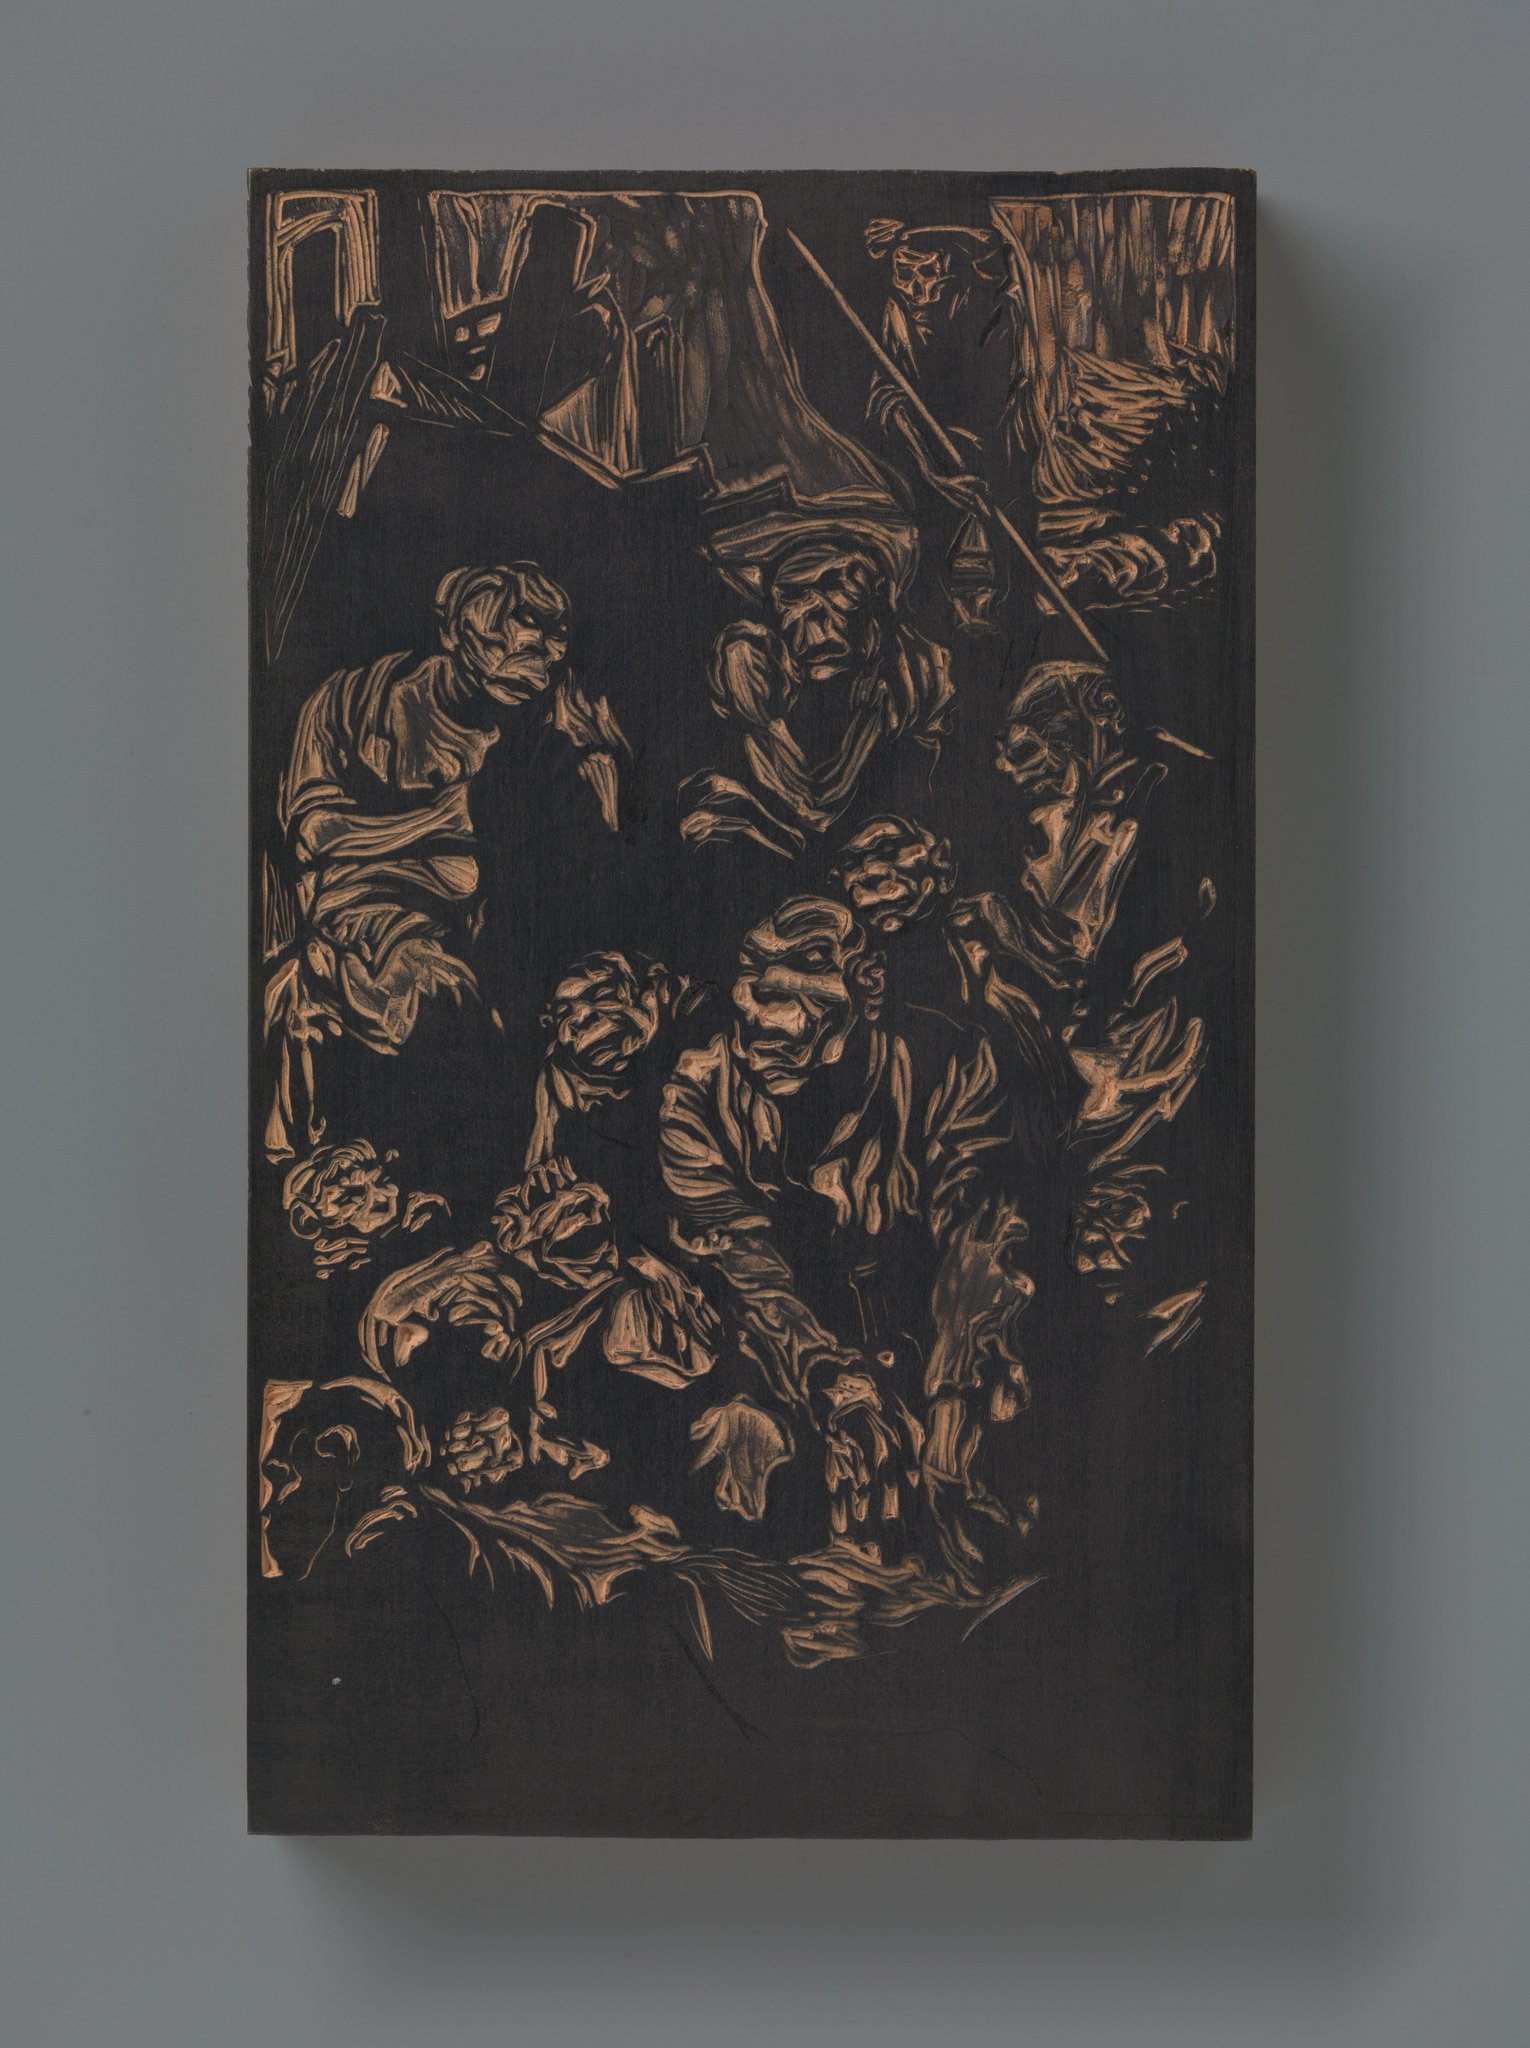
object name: wood block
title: Monsterfiguren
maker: johannes josephus aarts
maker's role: draughtsman, print maker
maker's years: 1871-1934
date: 1881-1934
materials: wood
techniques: woodcut